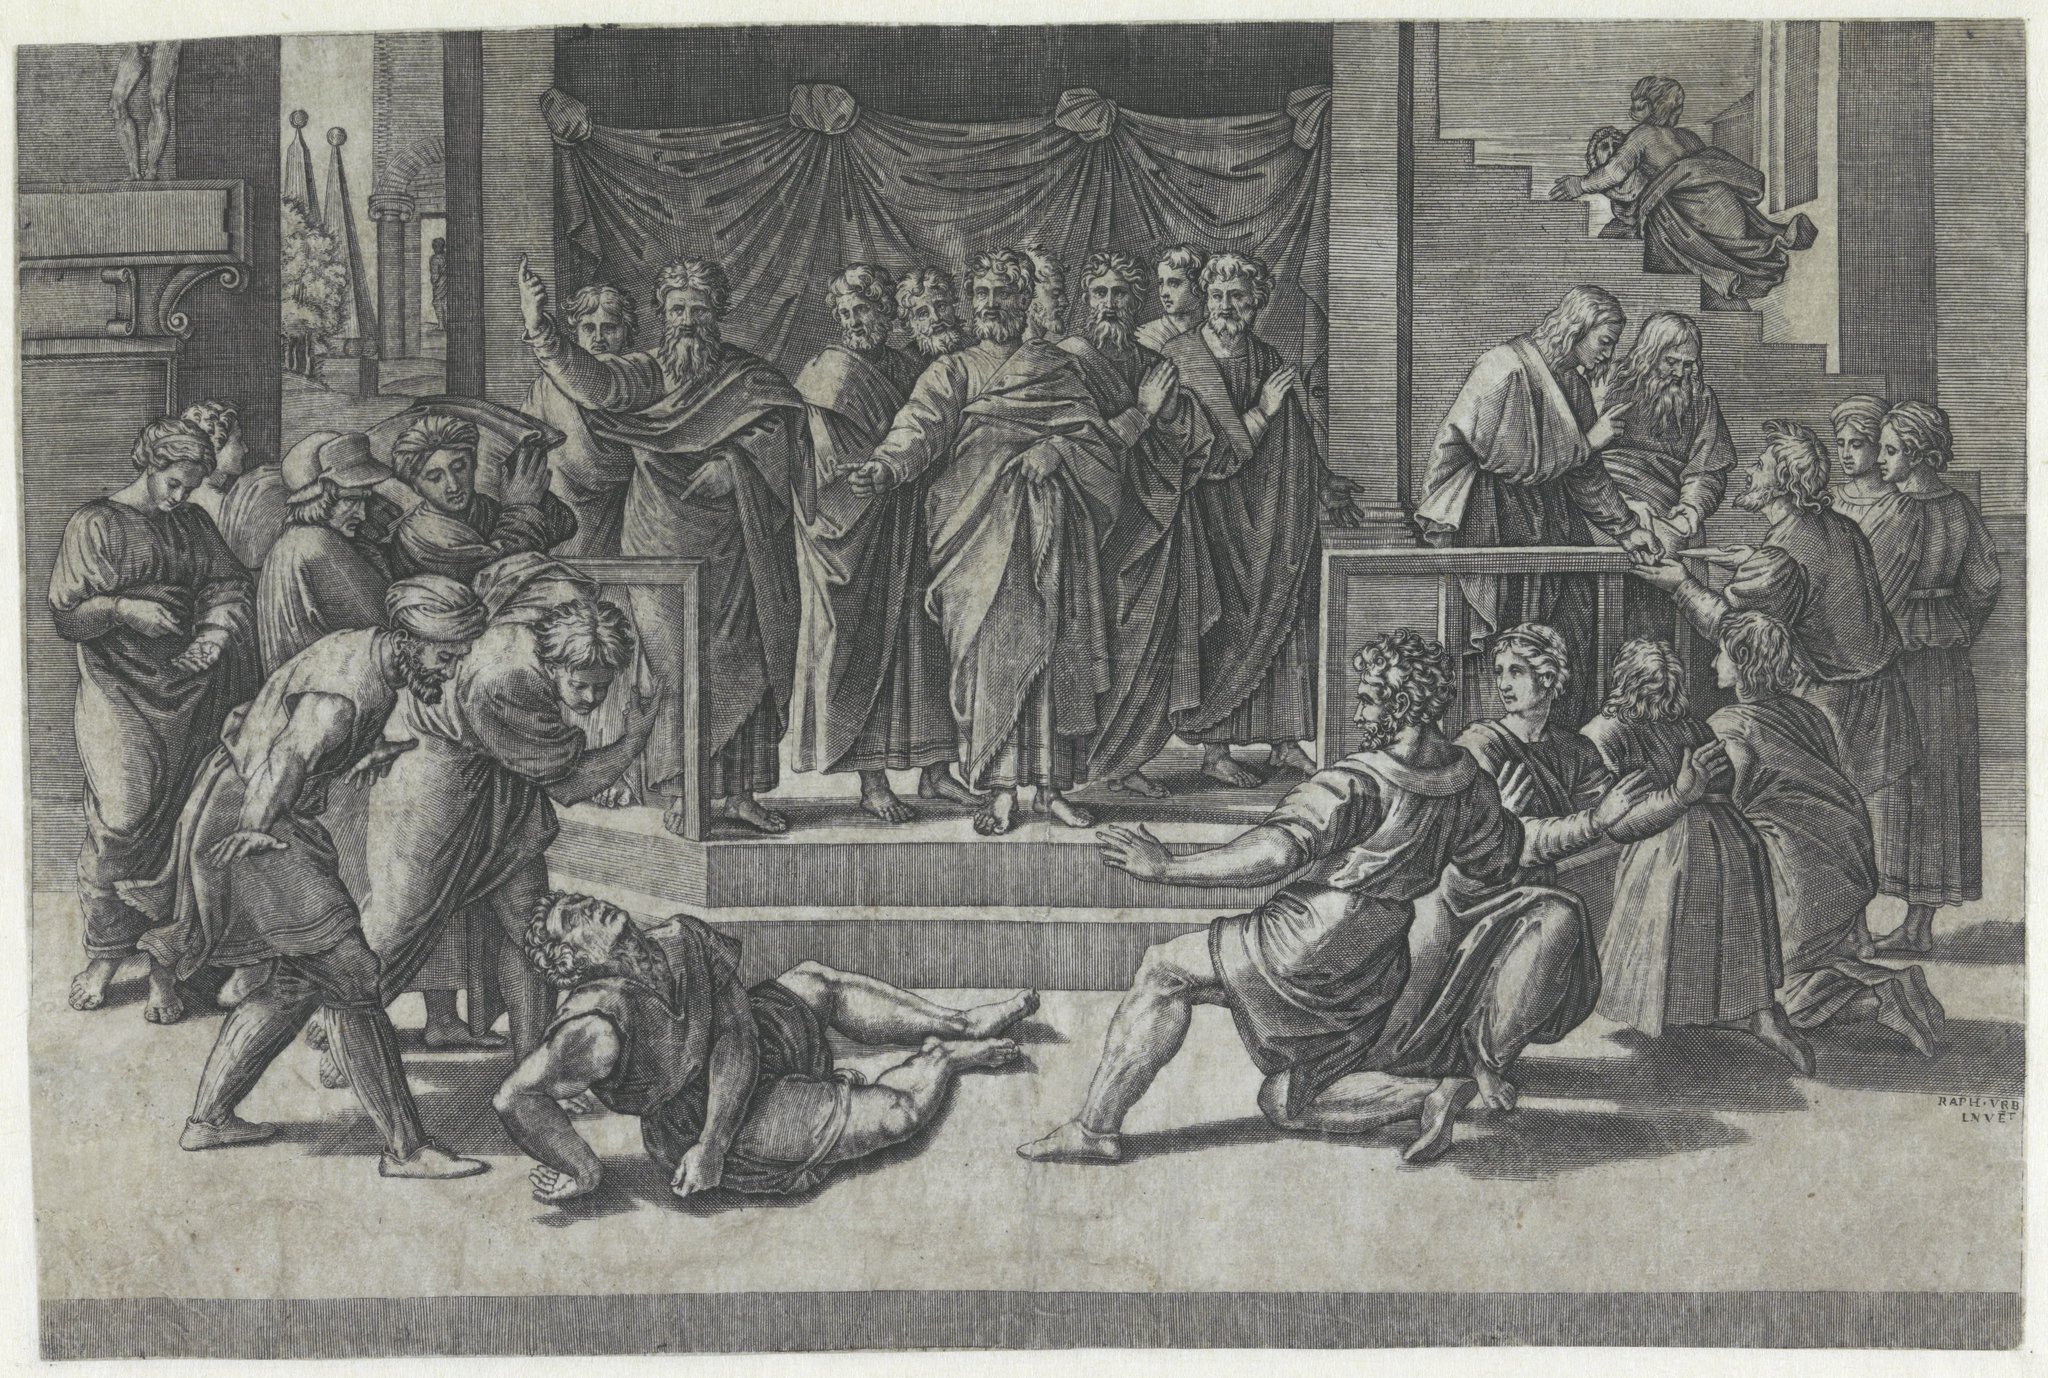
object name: print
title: Amor met schild en helm van Mars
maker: agostino veneziano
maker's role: draughtsman, painter, print maker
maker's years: 1490-1536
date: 1500-1536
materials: paper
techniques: engraving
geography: rome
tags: helmet, protective weapons: shield, (story of) cupid, amor (eros), attributes of mars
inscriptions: collector's mark: Lugt 12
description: Prent naar een detail van het fresco door Rafaël op het gewelf van de Loggia di Psiche in de Villa Farnesina te Rome.